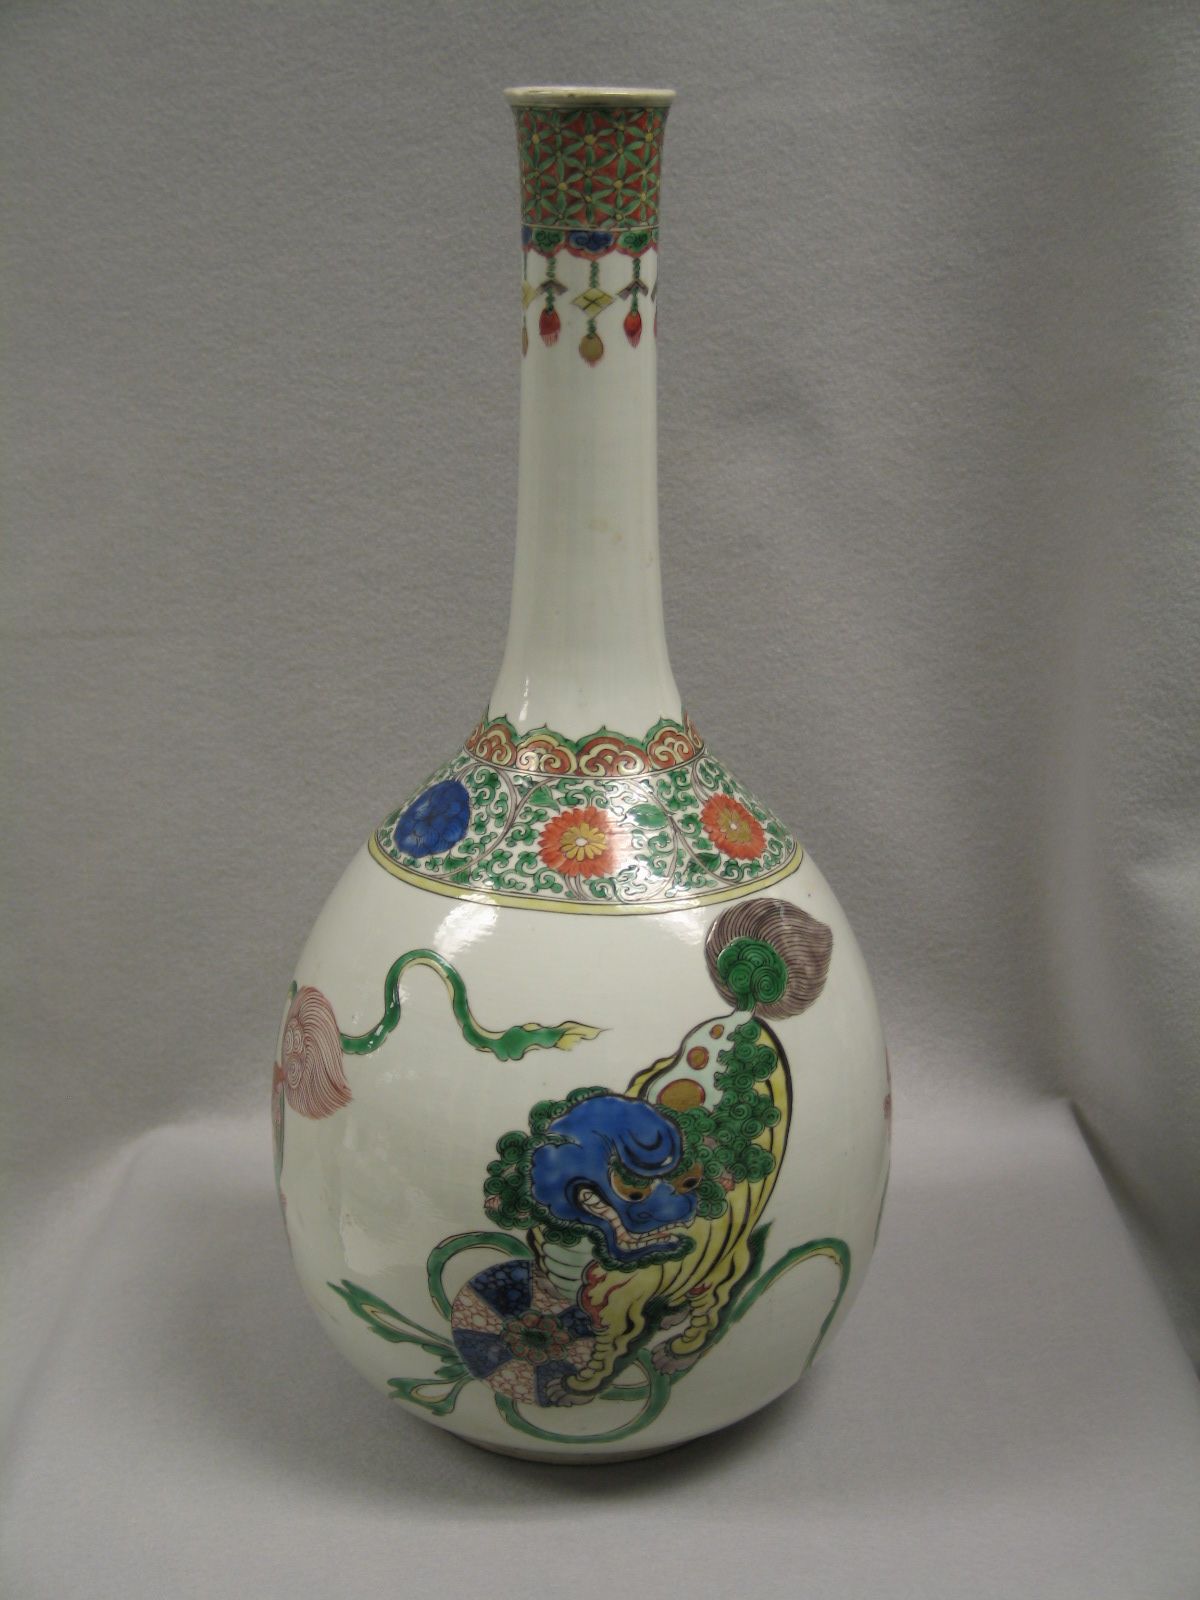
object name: bottle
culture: chinese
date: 1662-1722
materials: enamel, porcelain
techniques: painting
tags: mythical creatures,flowers